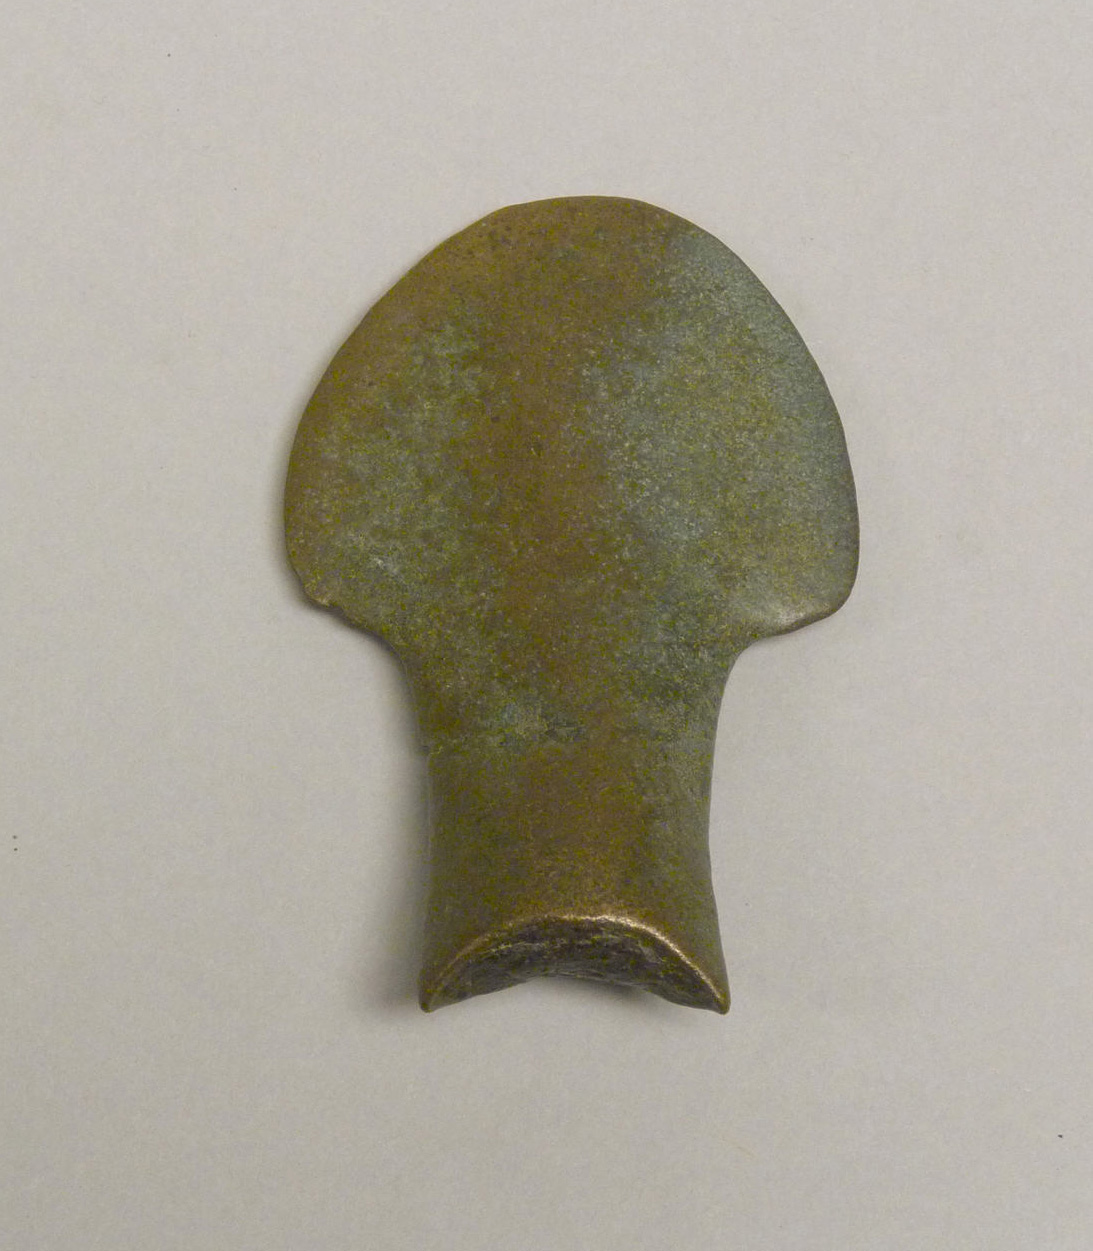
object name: ax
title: Hoe-Shaped Ax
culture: indonesian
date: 500 BCE-300 CE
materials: bronze